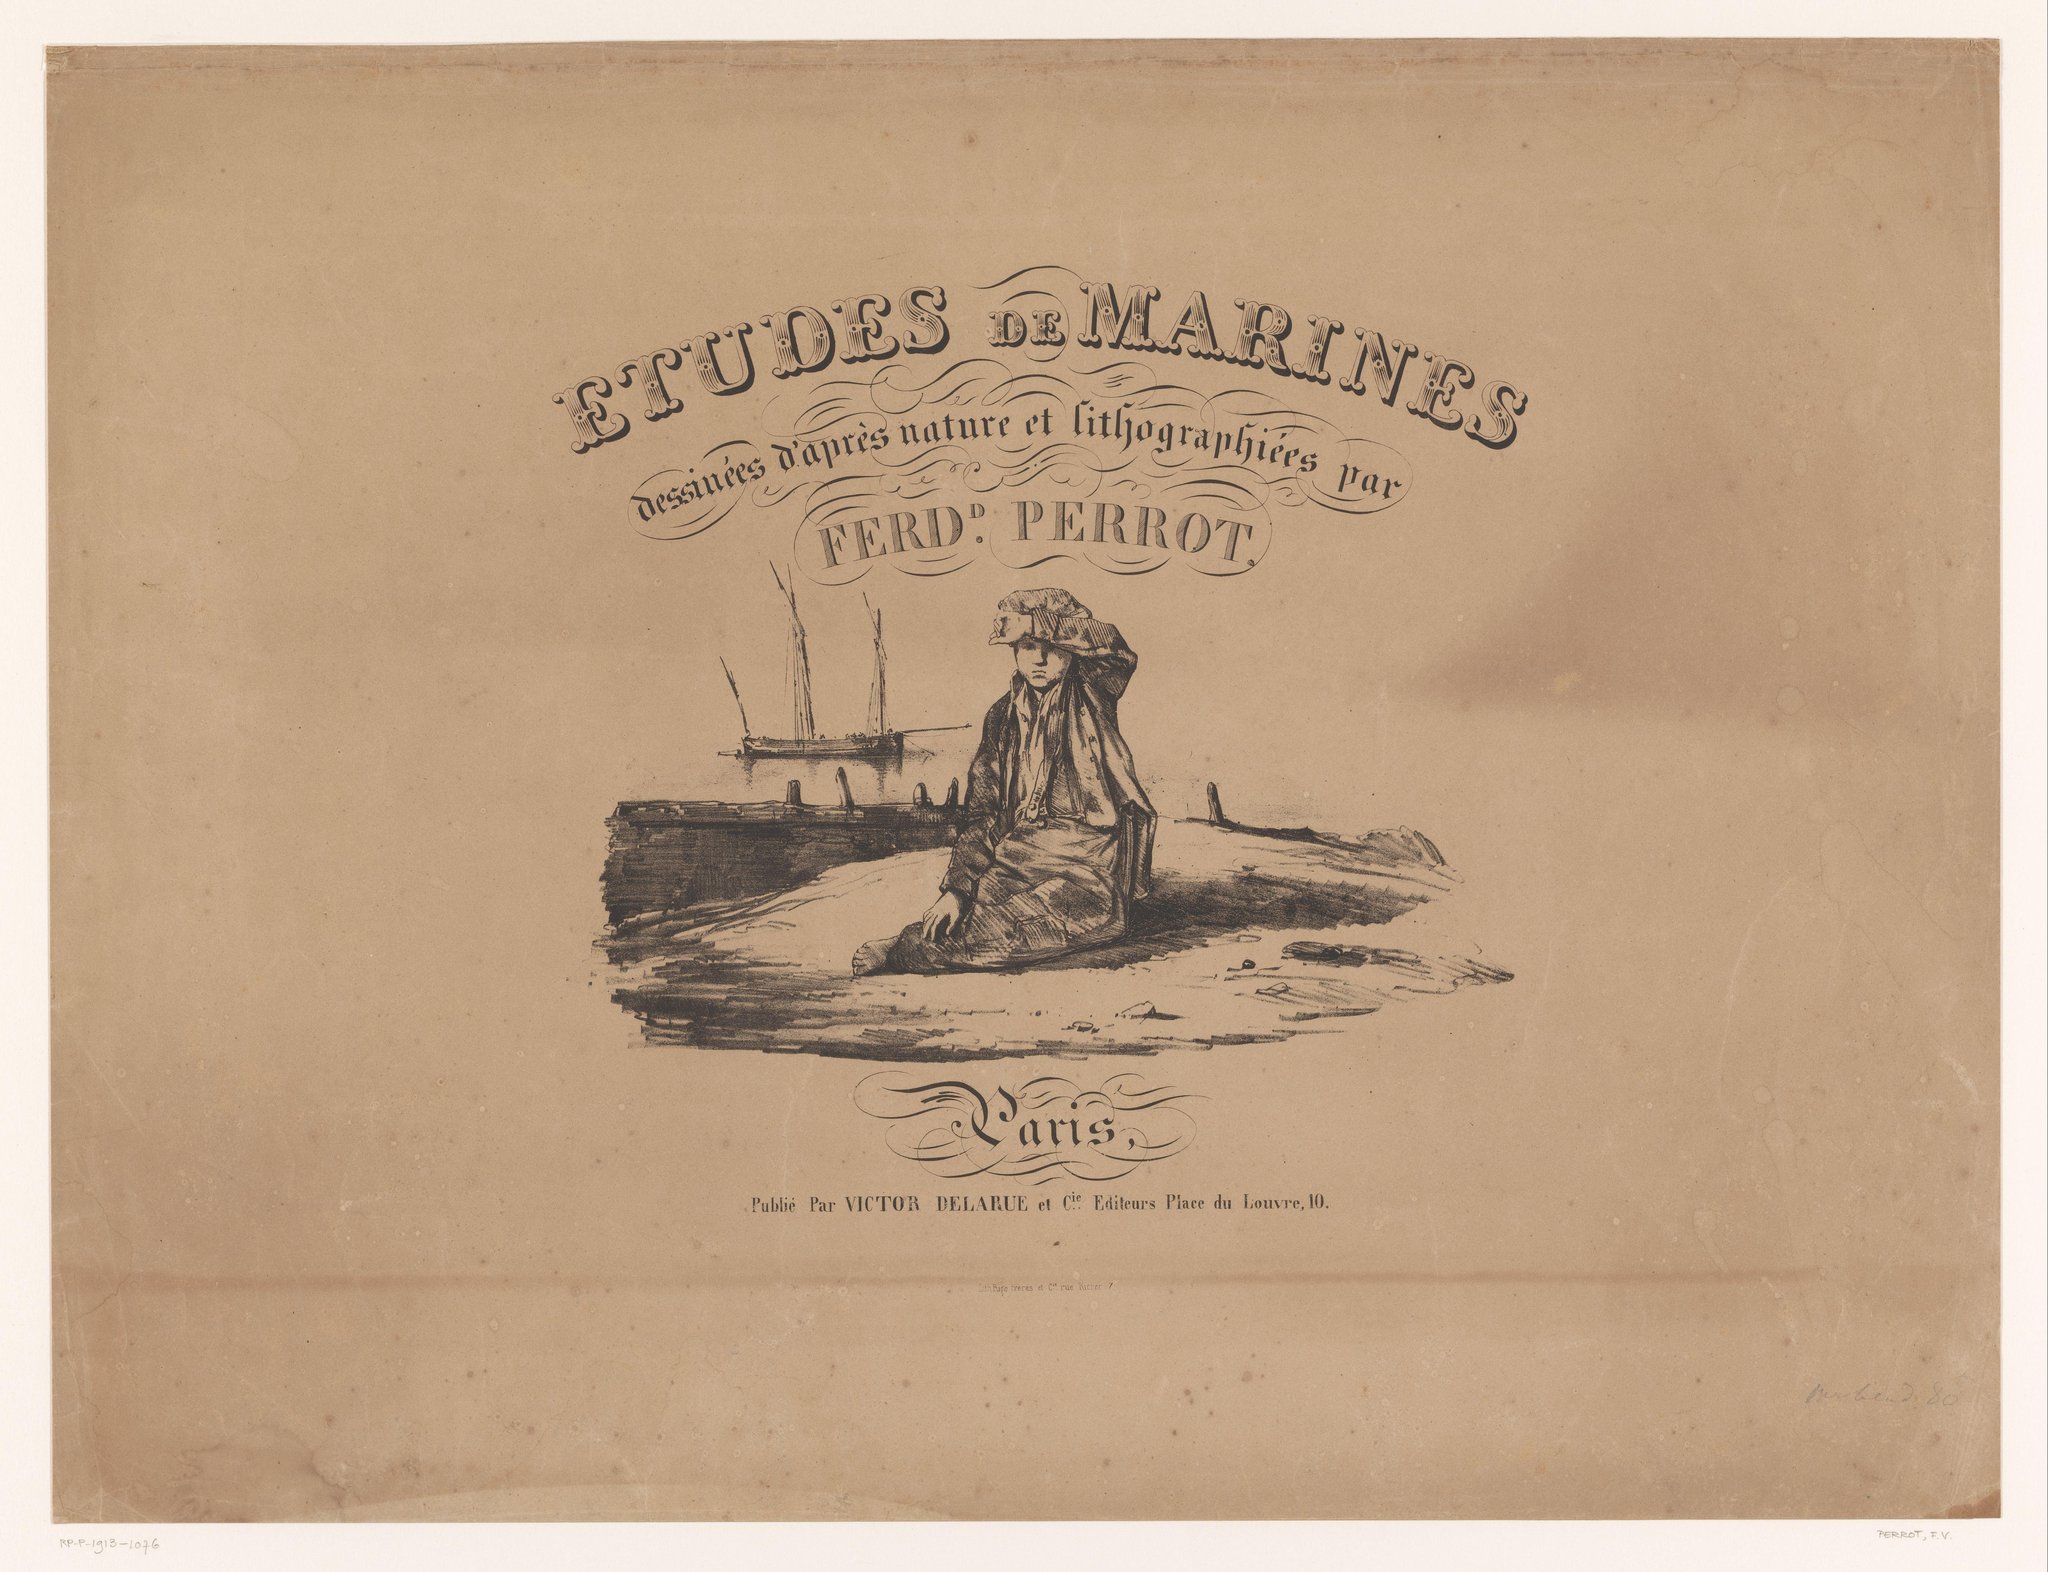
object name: print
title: Omslag voor prenten van studies van schepen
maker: ferdinand victor perrot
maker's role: print maker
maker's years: 1808-1841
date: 1839-1852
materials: paper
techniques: lithograph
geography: paris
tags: ship's portrait, boy (child between toddler and youth)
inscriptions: collector's mark: Lugt 2228